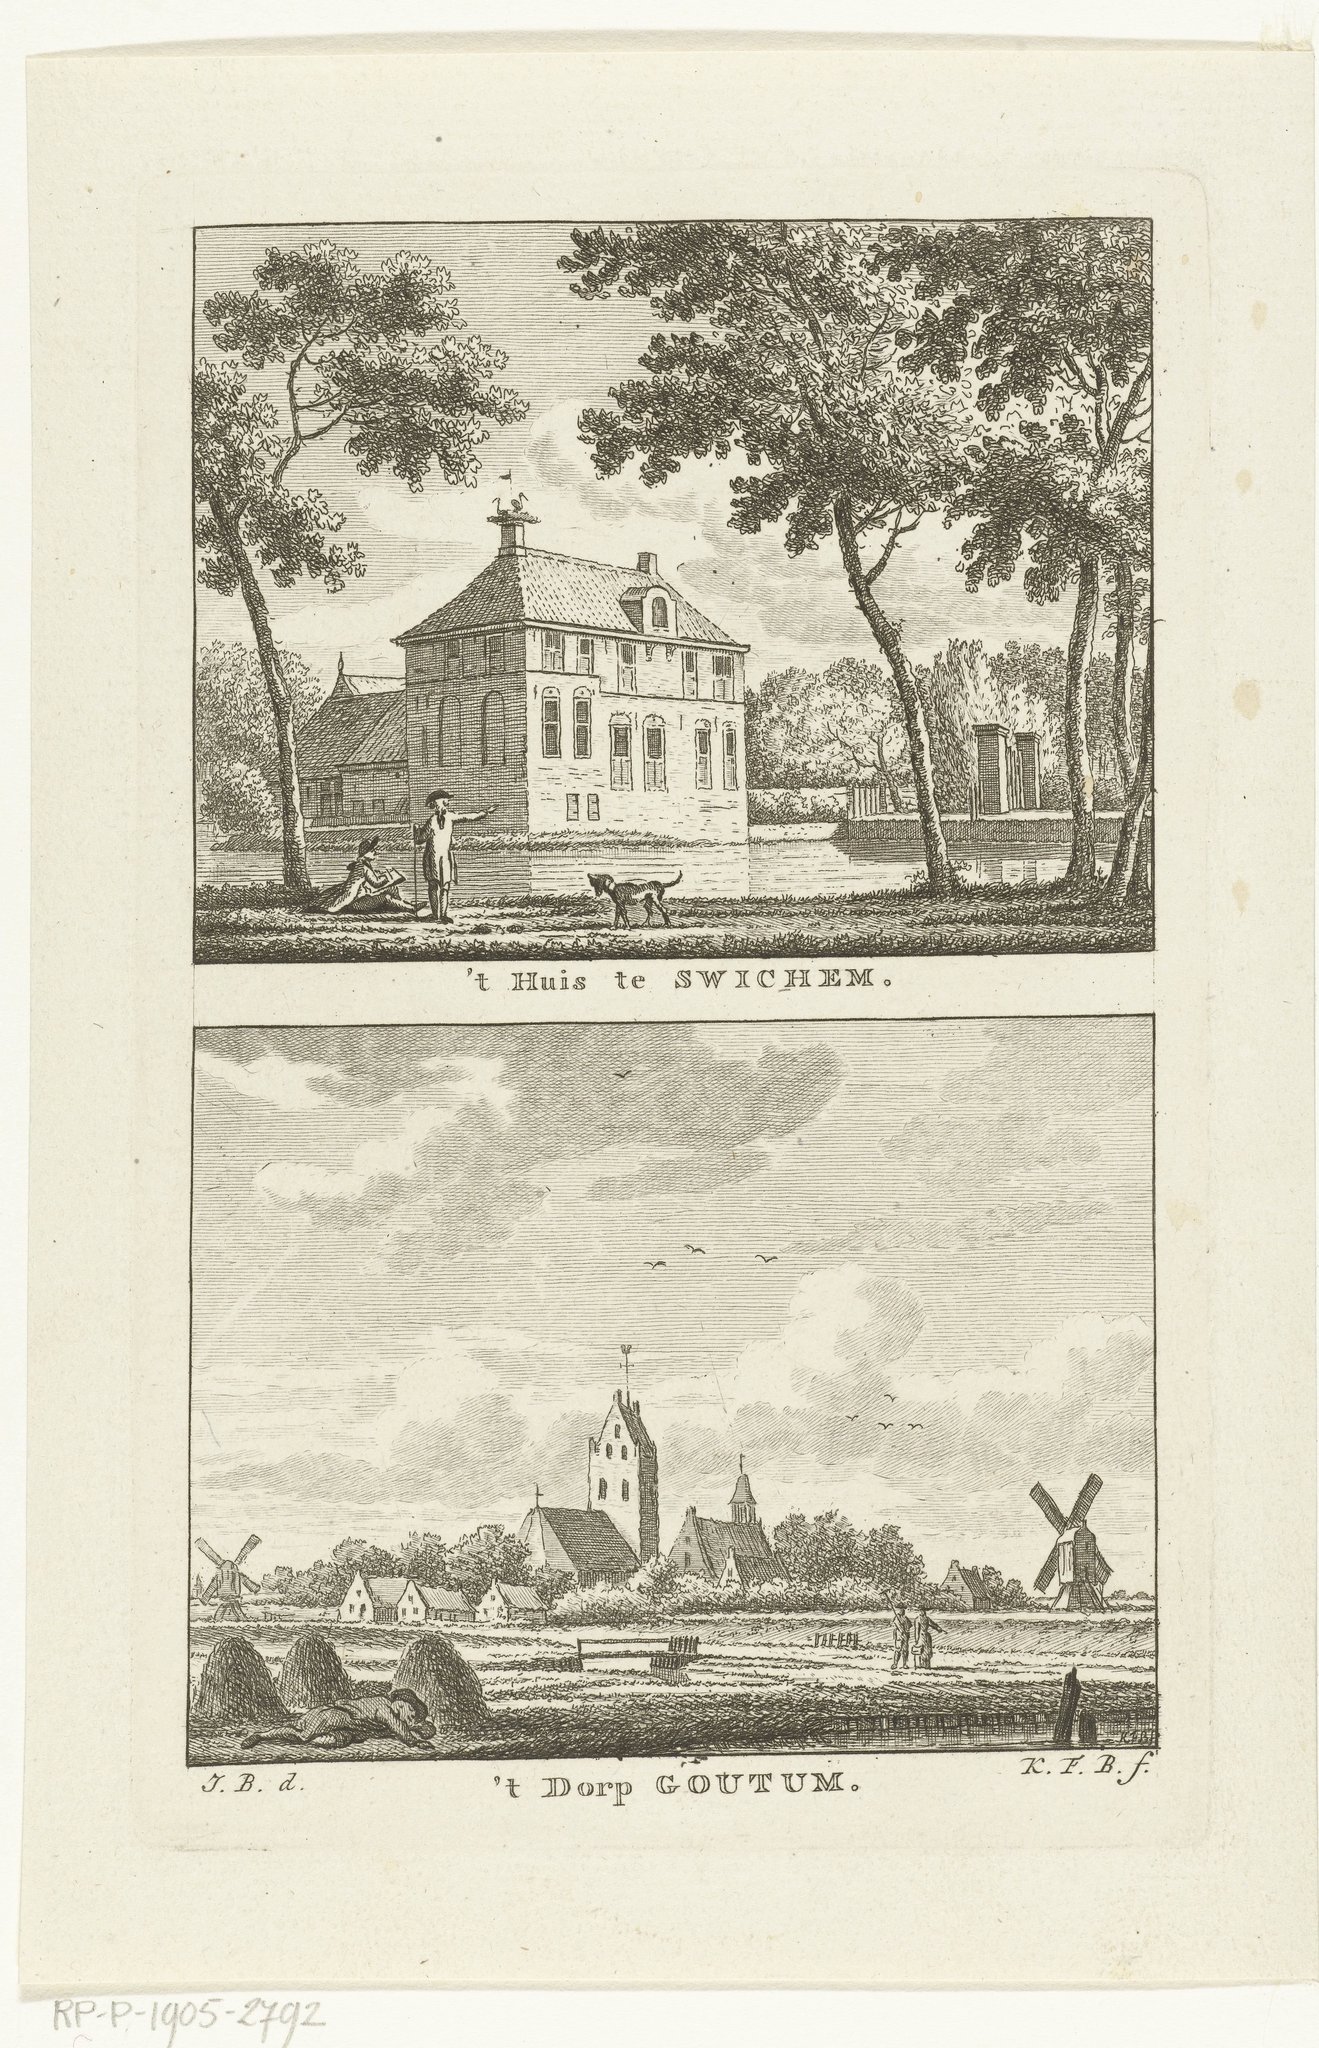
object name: print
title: 't Huis te Swichem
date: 1786-1792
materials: paper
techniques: etching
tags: village, country-house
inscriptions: collector's mark: Lugt 2228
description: Prent uit: Vaderlandsche gezichten, of afbeeldingen van den tegenwoordigen staat der Vereenigde Nederlanden (…). Amsterdam: Hendrik Gartman, Willem Vermandel en Jan Willem Smit, 1786-1792. Uitgegeven in afleveringen met ieder een eigen bifolium en inhoudsopgave. Alle prenten in deze publicatie zijn gegraveerd door Carel Frederik Bendorp (I) en, in de meeste gevallen, gebaseerd op tekeningen van Jan Bulthuis.